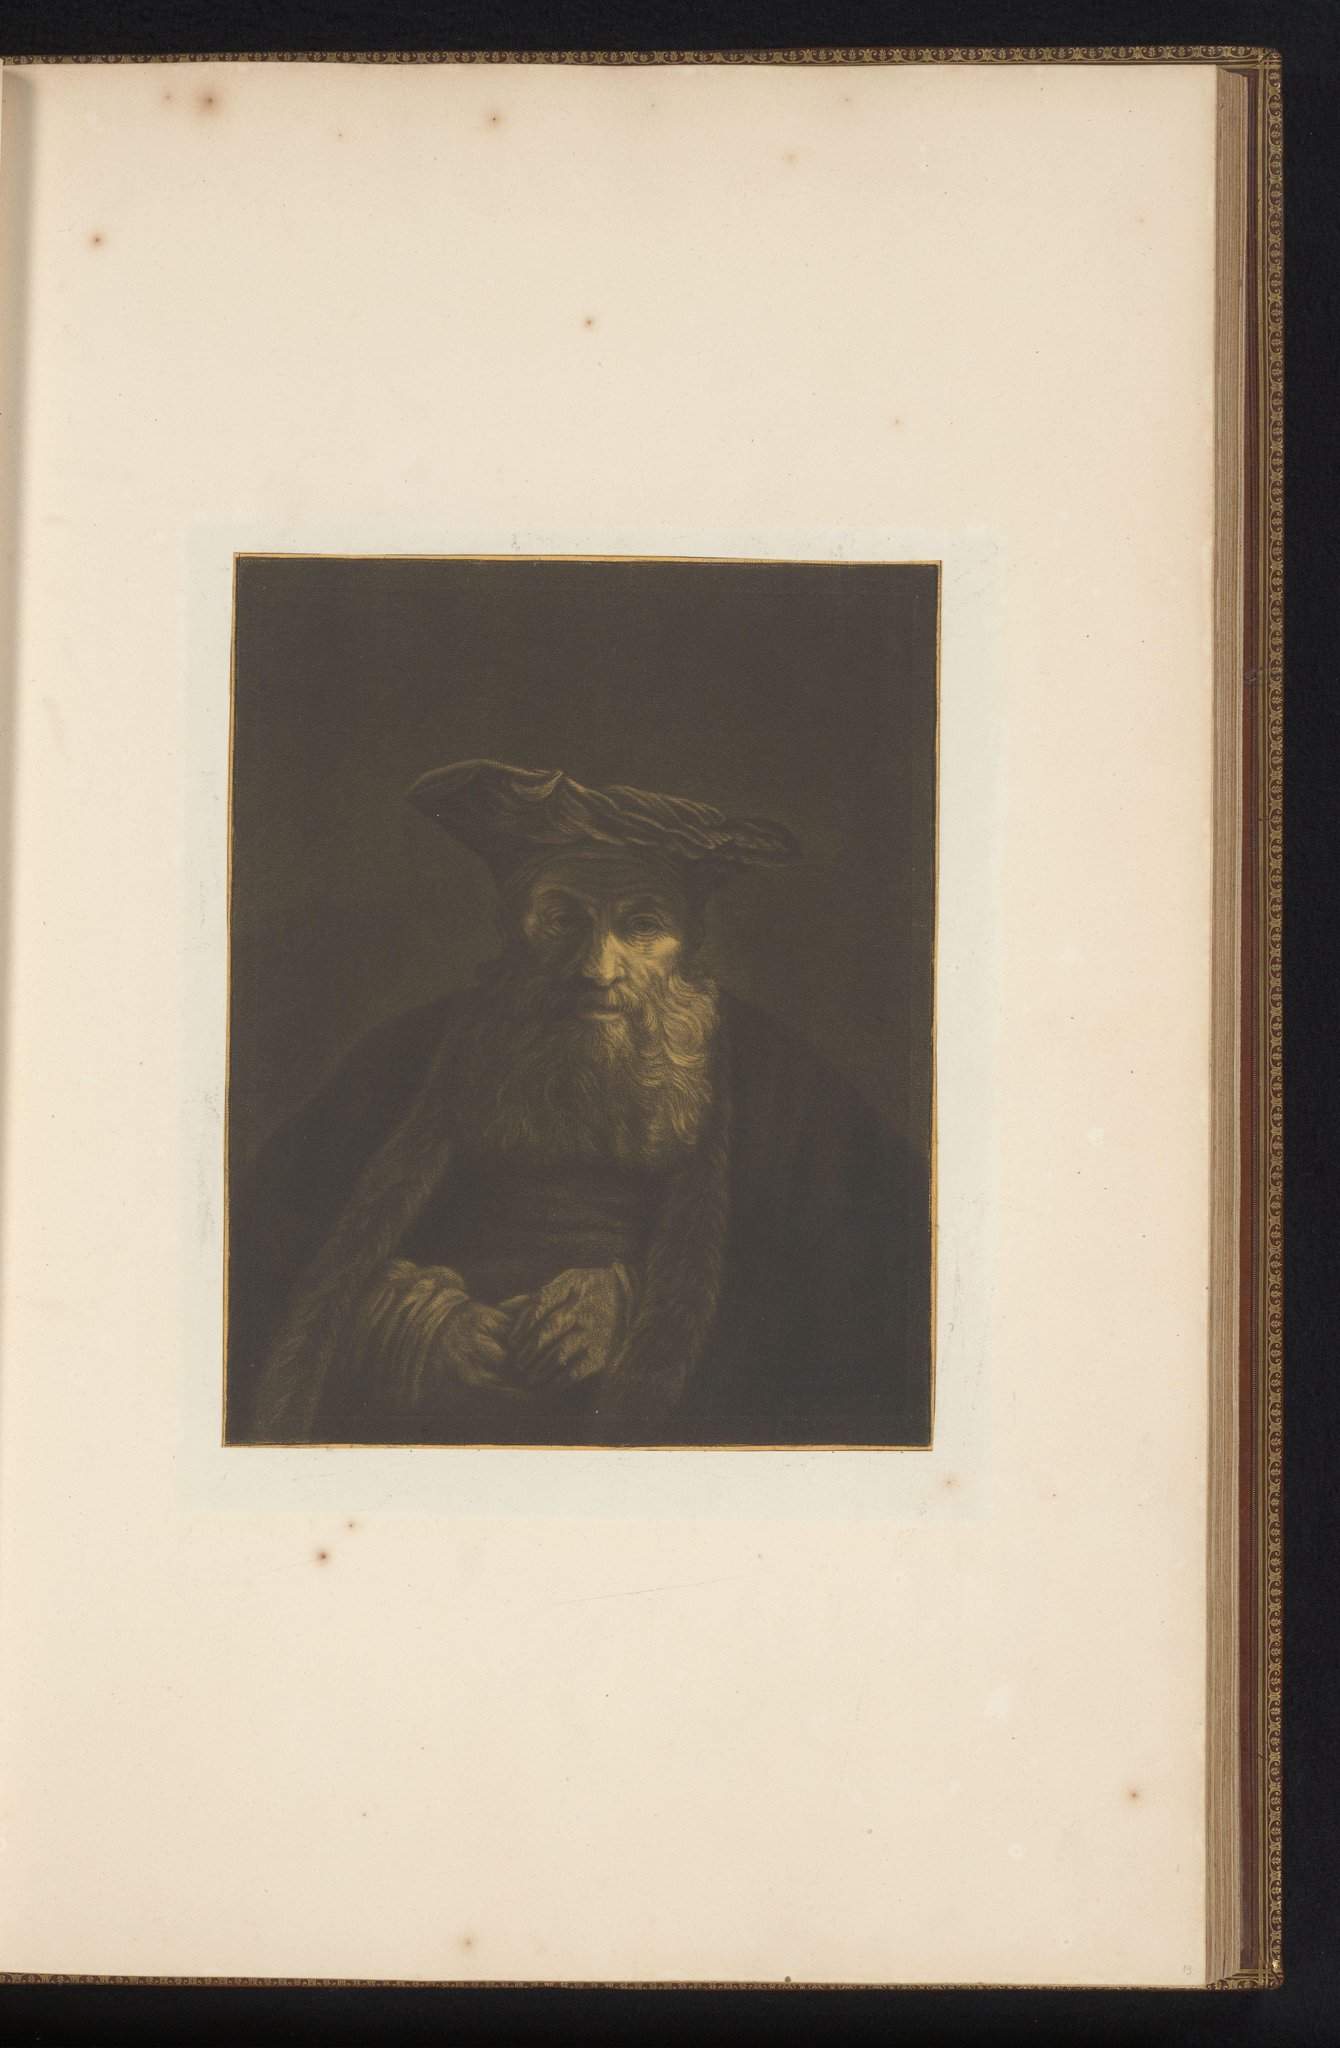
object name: print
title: Oude man met lange baard en platte hoed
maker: william baillie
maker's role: print maker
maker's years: 1723-1810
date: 1753-1810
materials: paper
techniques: etching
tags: old man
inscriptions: stamp